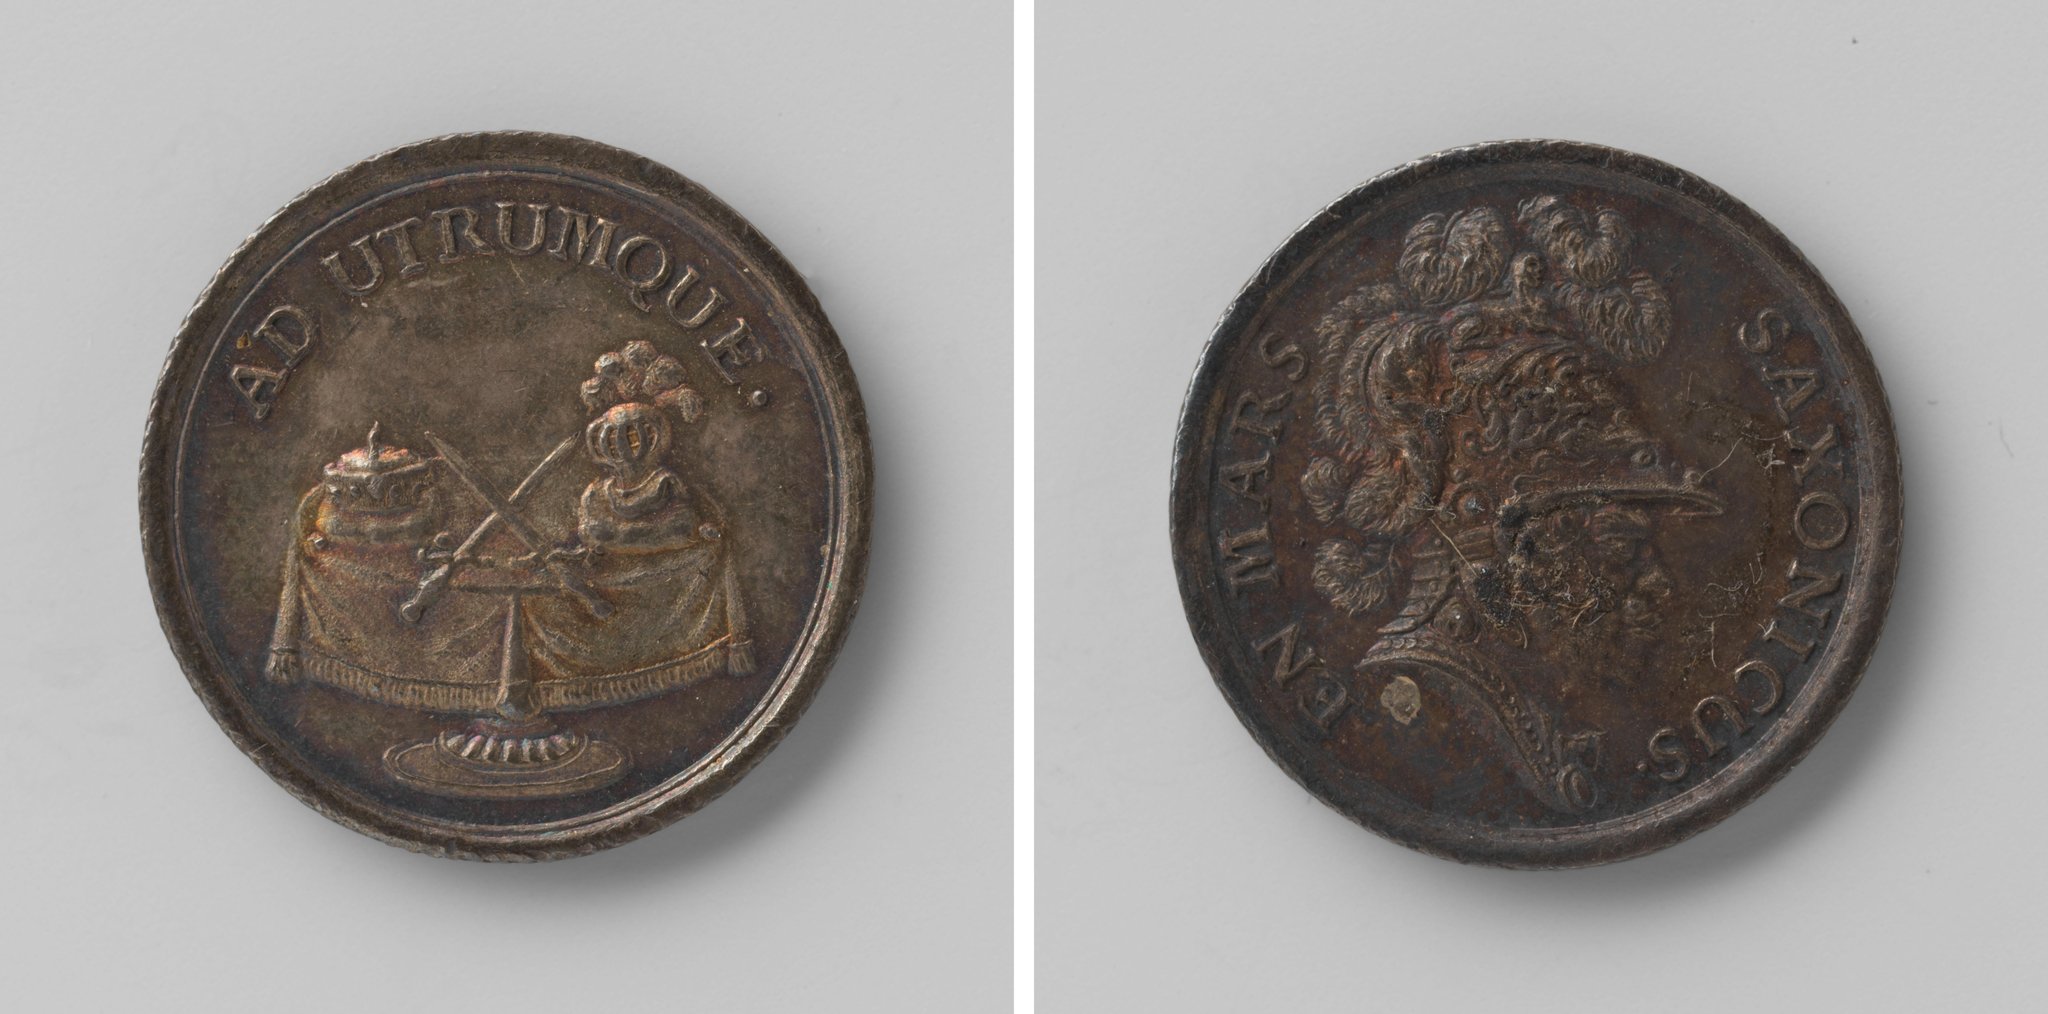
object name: strooipenning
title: Johan Georg III, hertog van Saksen trekt over de Rijn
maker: Anonymous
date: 1691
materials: silver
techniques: striking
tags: tübingen, keurvorst, keurvorst van saksen johan georg iii, rijn, johan georg iii steekt rijn over, negenjarige oorlog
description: Zilveren penning. Voorzijde: borststuk man met helm binnen omschrift. Keerzijde: tafel met daarop twee gekruiste degens tussen keurvorstelijke helm en muts binnen omschrift